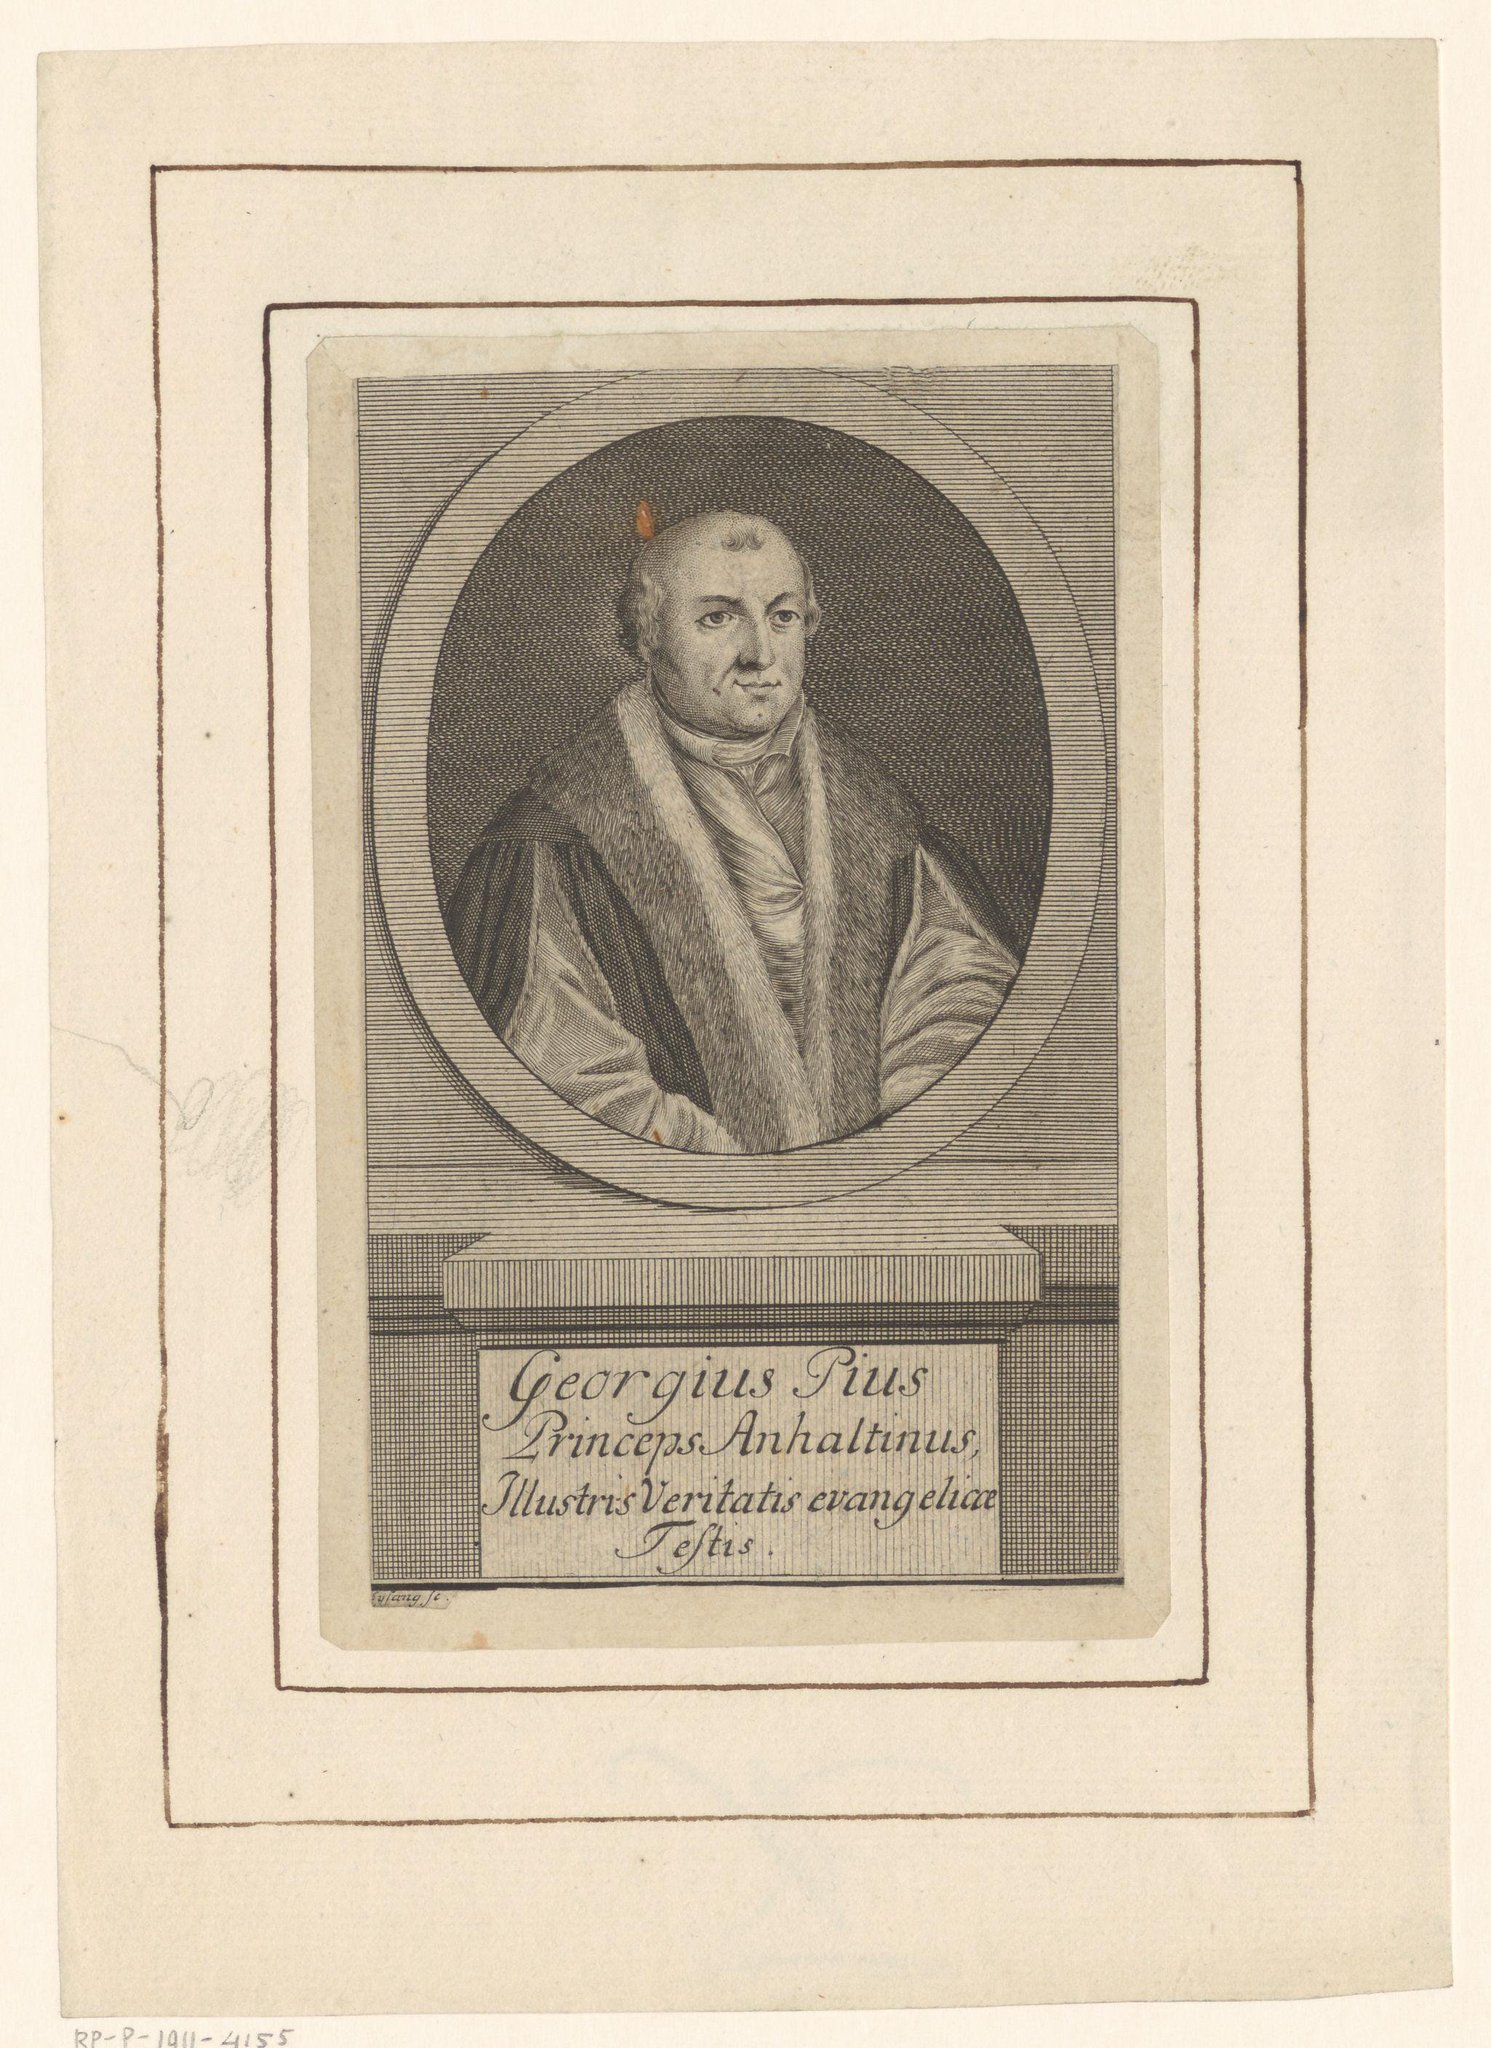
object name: print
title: Portret van Georg III, prins van Anhalt-Dessau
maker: johann christoph sysang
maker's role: print maker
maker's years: 1703-1757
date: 1713-1757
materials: paper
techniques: engraving, etching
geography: germany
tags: historical persons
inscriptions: collector's mark: Lugt 2228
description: Prent is gemonteerd op een opzetvel voorzien van een dubbel kader met pen in bruin.